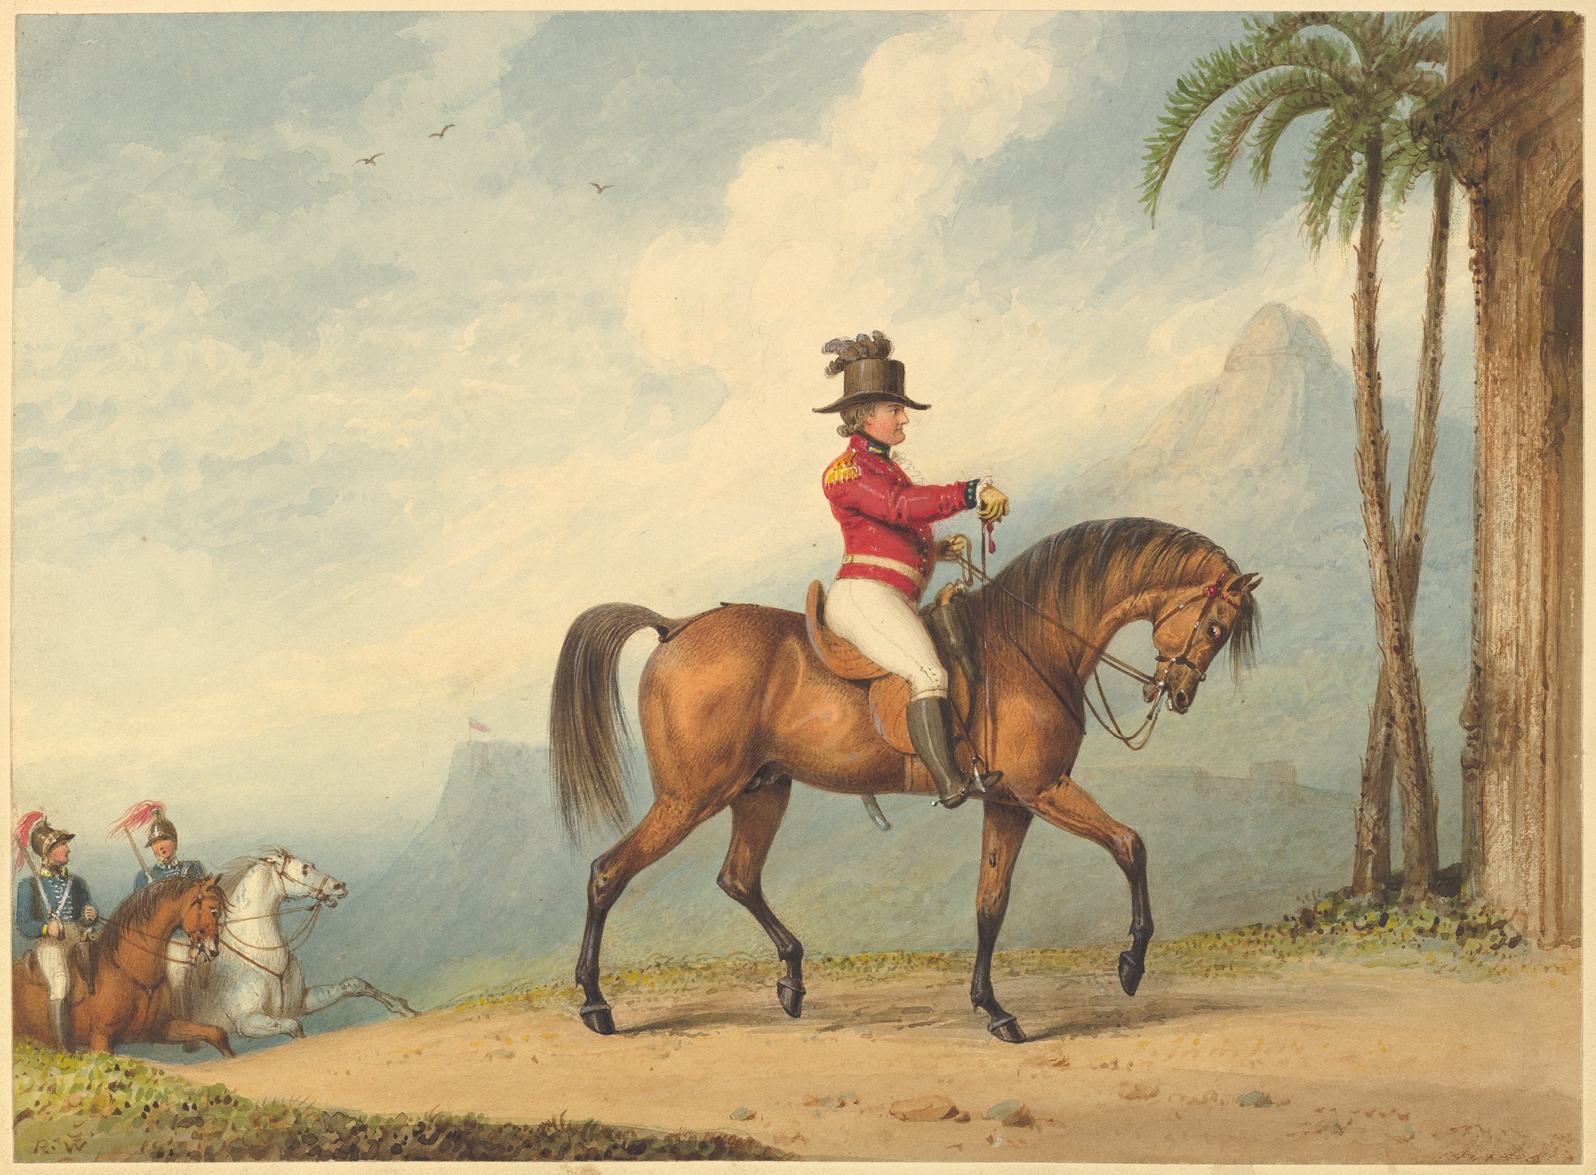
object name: drawing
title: Sir John Floyd on horseback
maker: richard westall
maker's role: artist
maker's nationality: british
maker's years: 1765-1836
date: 1800-1814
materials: watercolor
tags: soldiers,men,horses